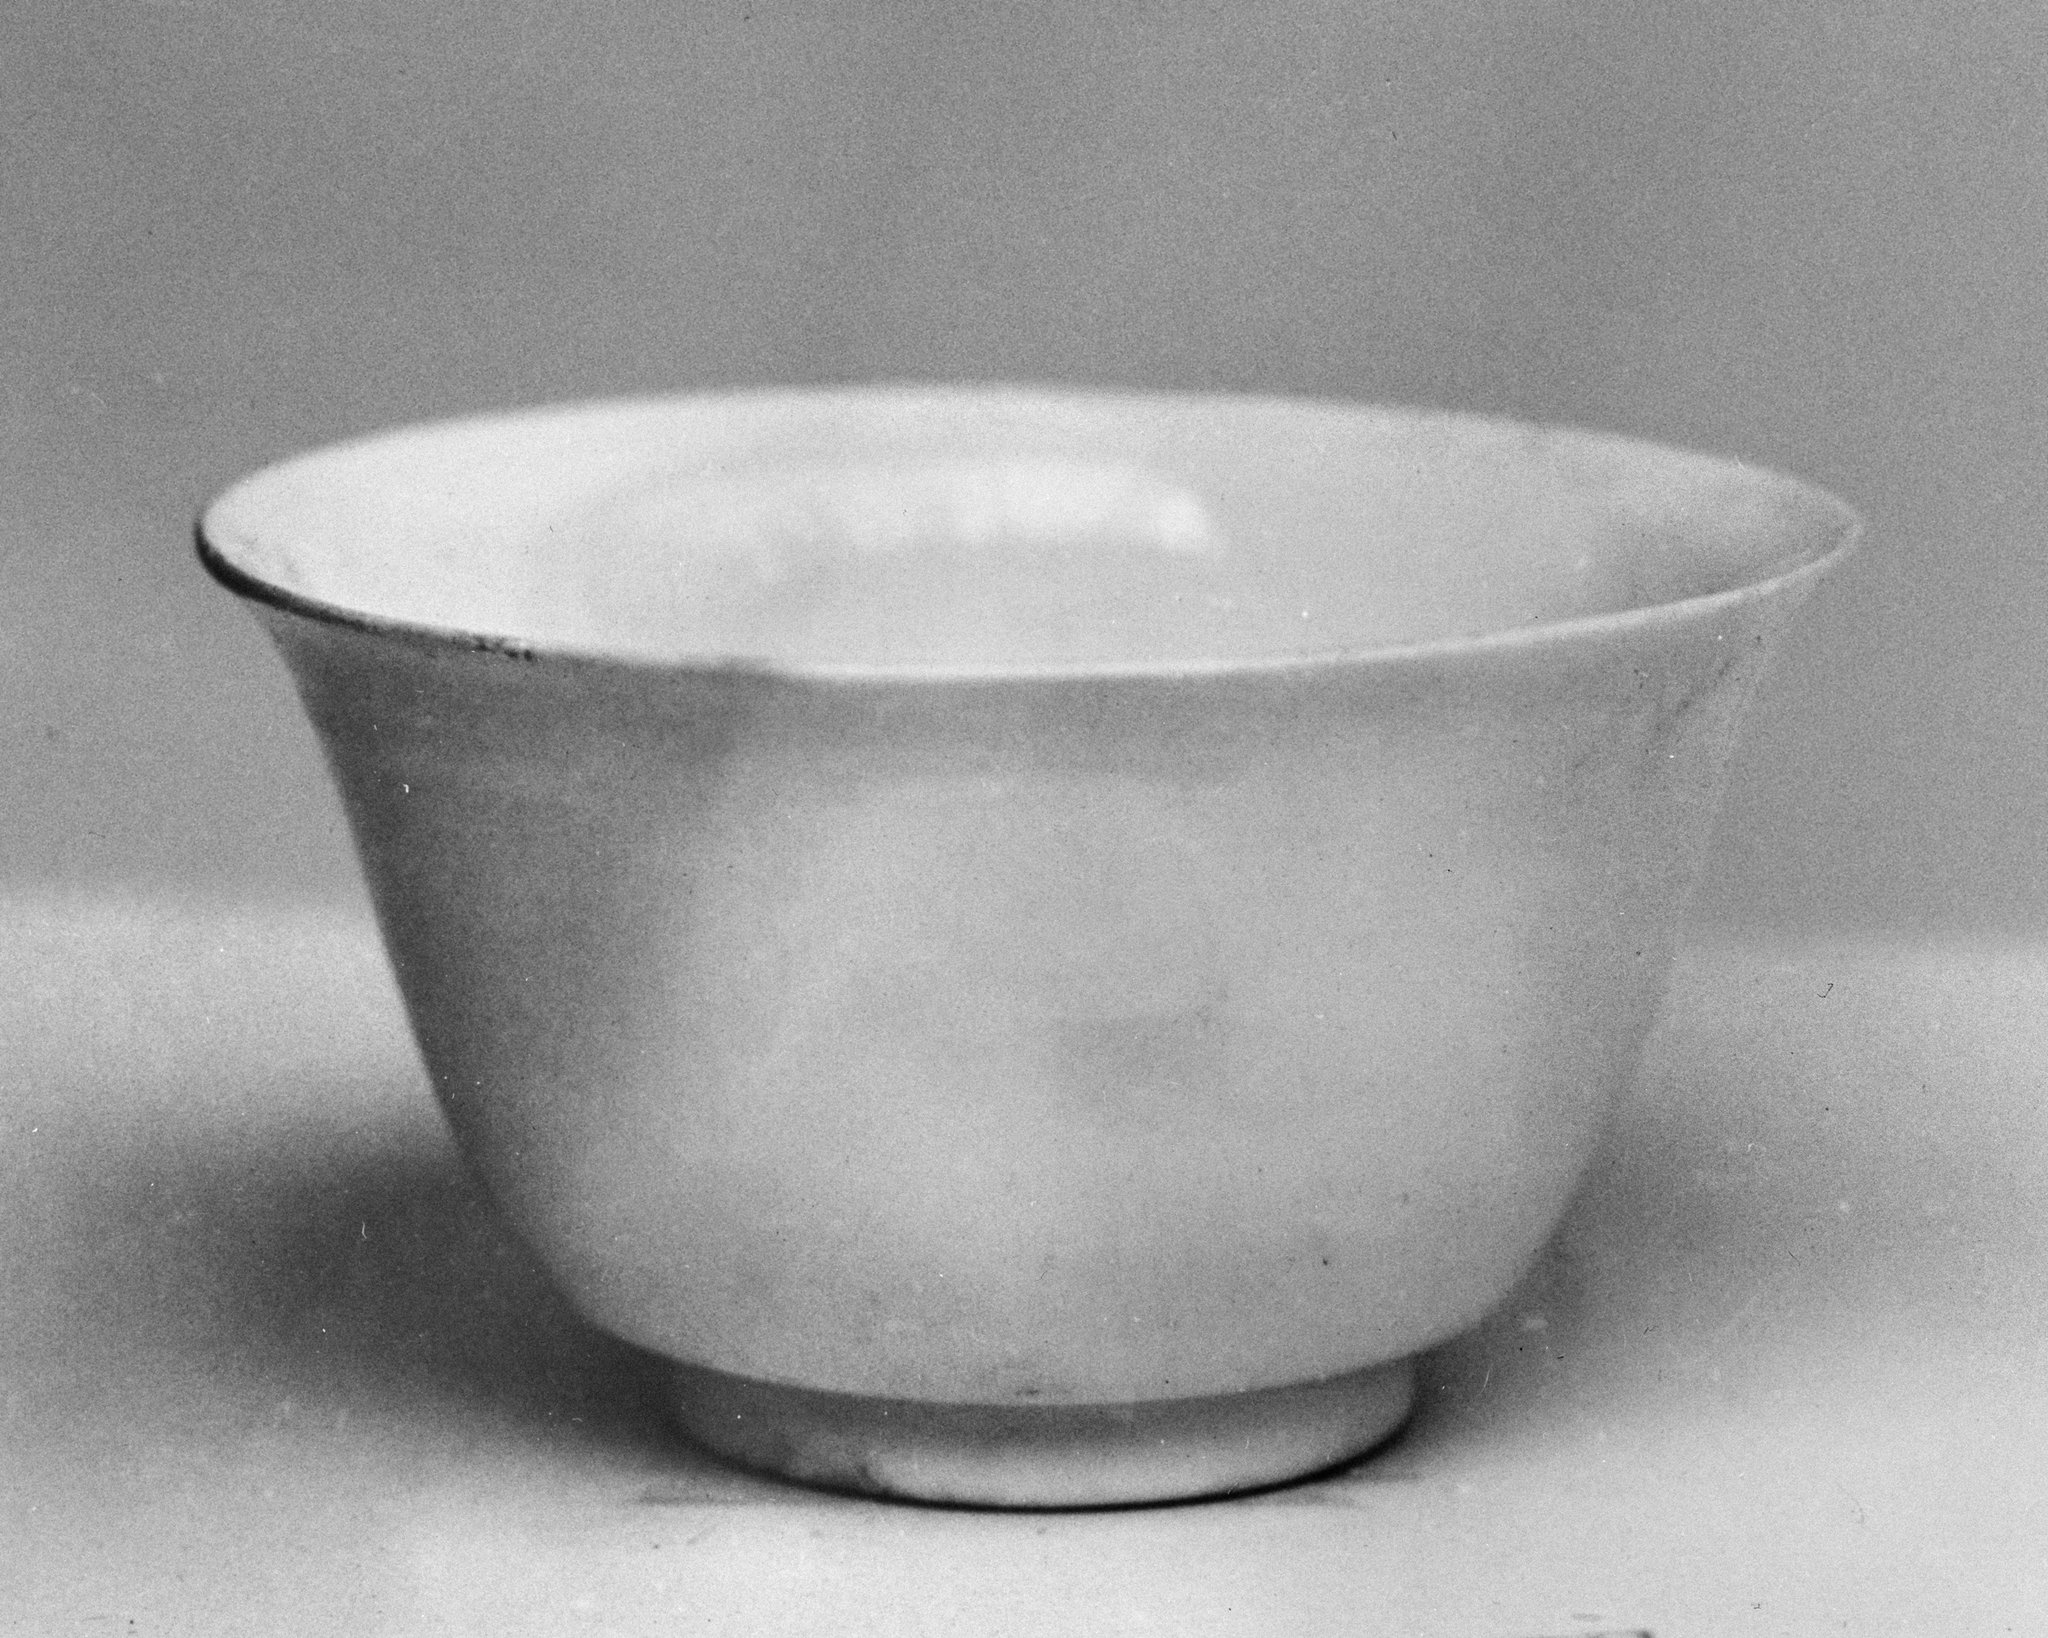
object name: cup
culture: chinese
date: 1501-1600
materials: glaze, porcelain